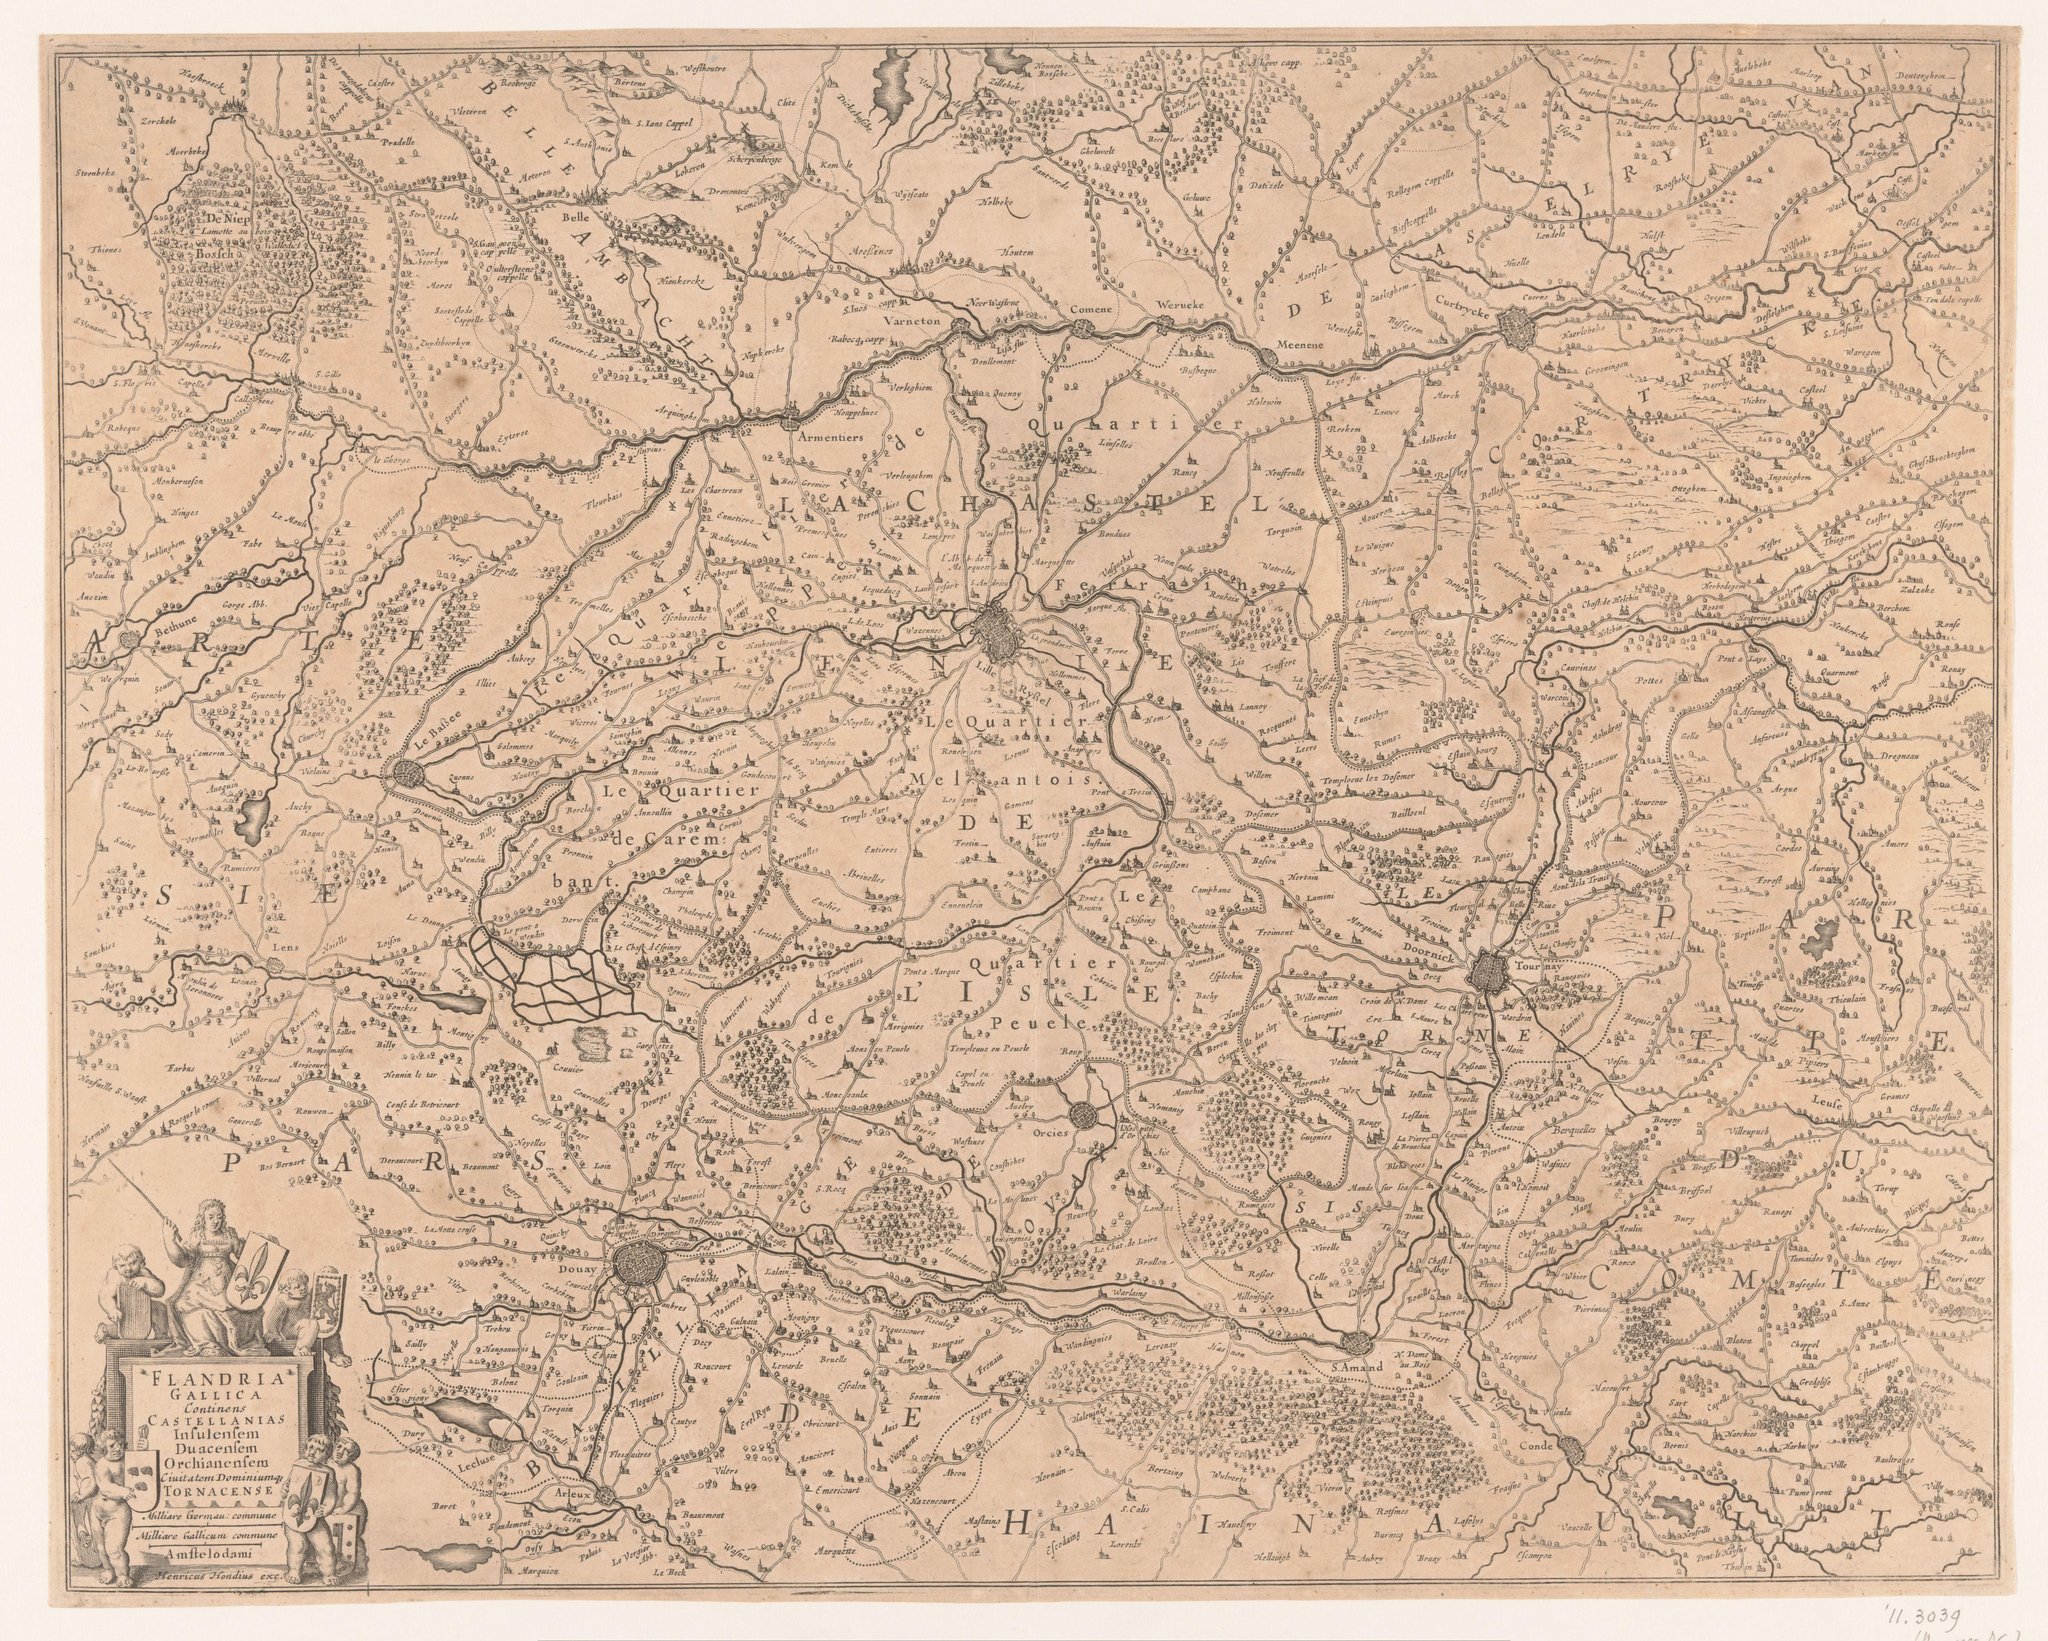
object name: map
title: Flandria Gallica Continens Castellanias Insulensem, Duacensem, Orchianensem, Civitatem Dominiumq Tornacense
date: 1633-1649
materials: paper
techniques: engraving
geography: amsterdam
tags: maps, atlases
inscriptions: collector's mark: Lugt 2228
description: Kaart van het Franse deel van het gebied Vlaanderen. De cartouche heeft een omlijsting bestaande uit schilddragende putti en bovenaan een personificatie van het gebied met op haar schild een Franse lelie.